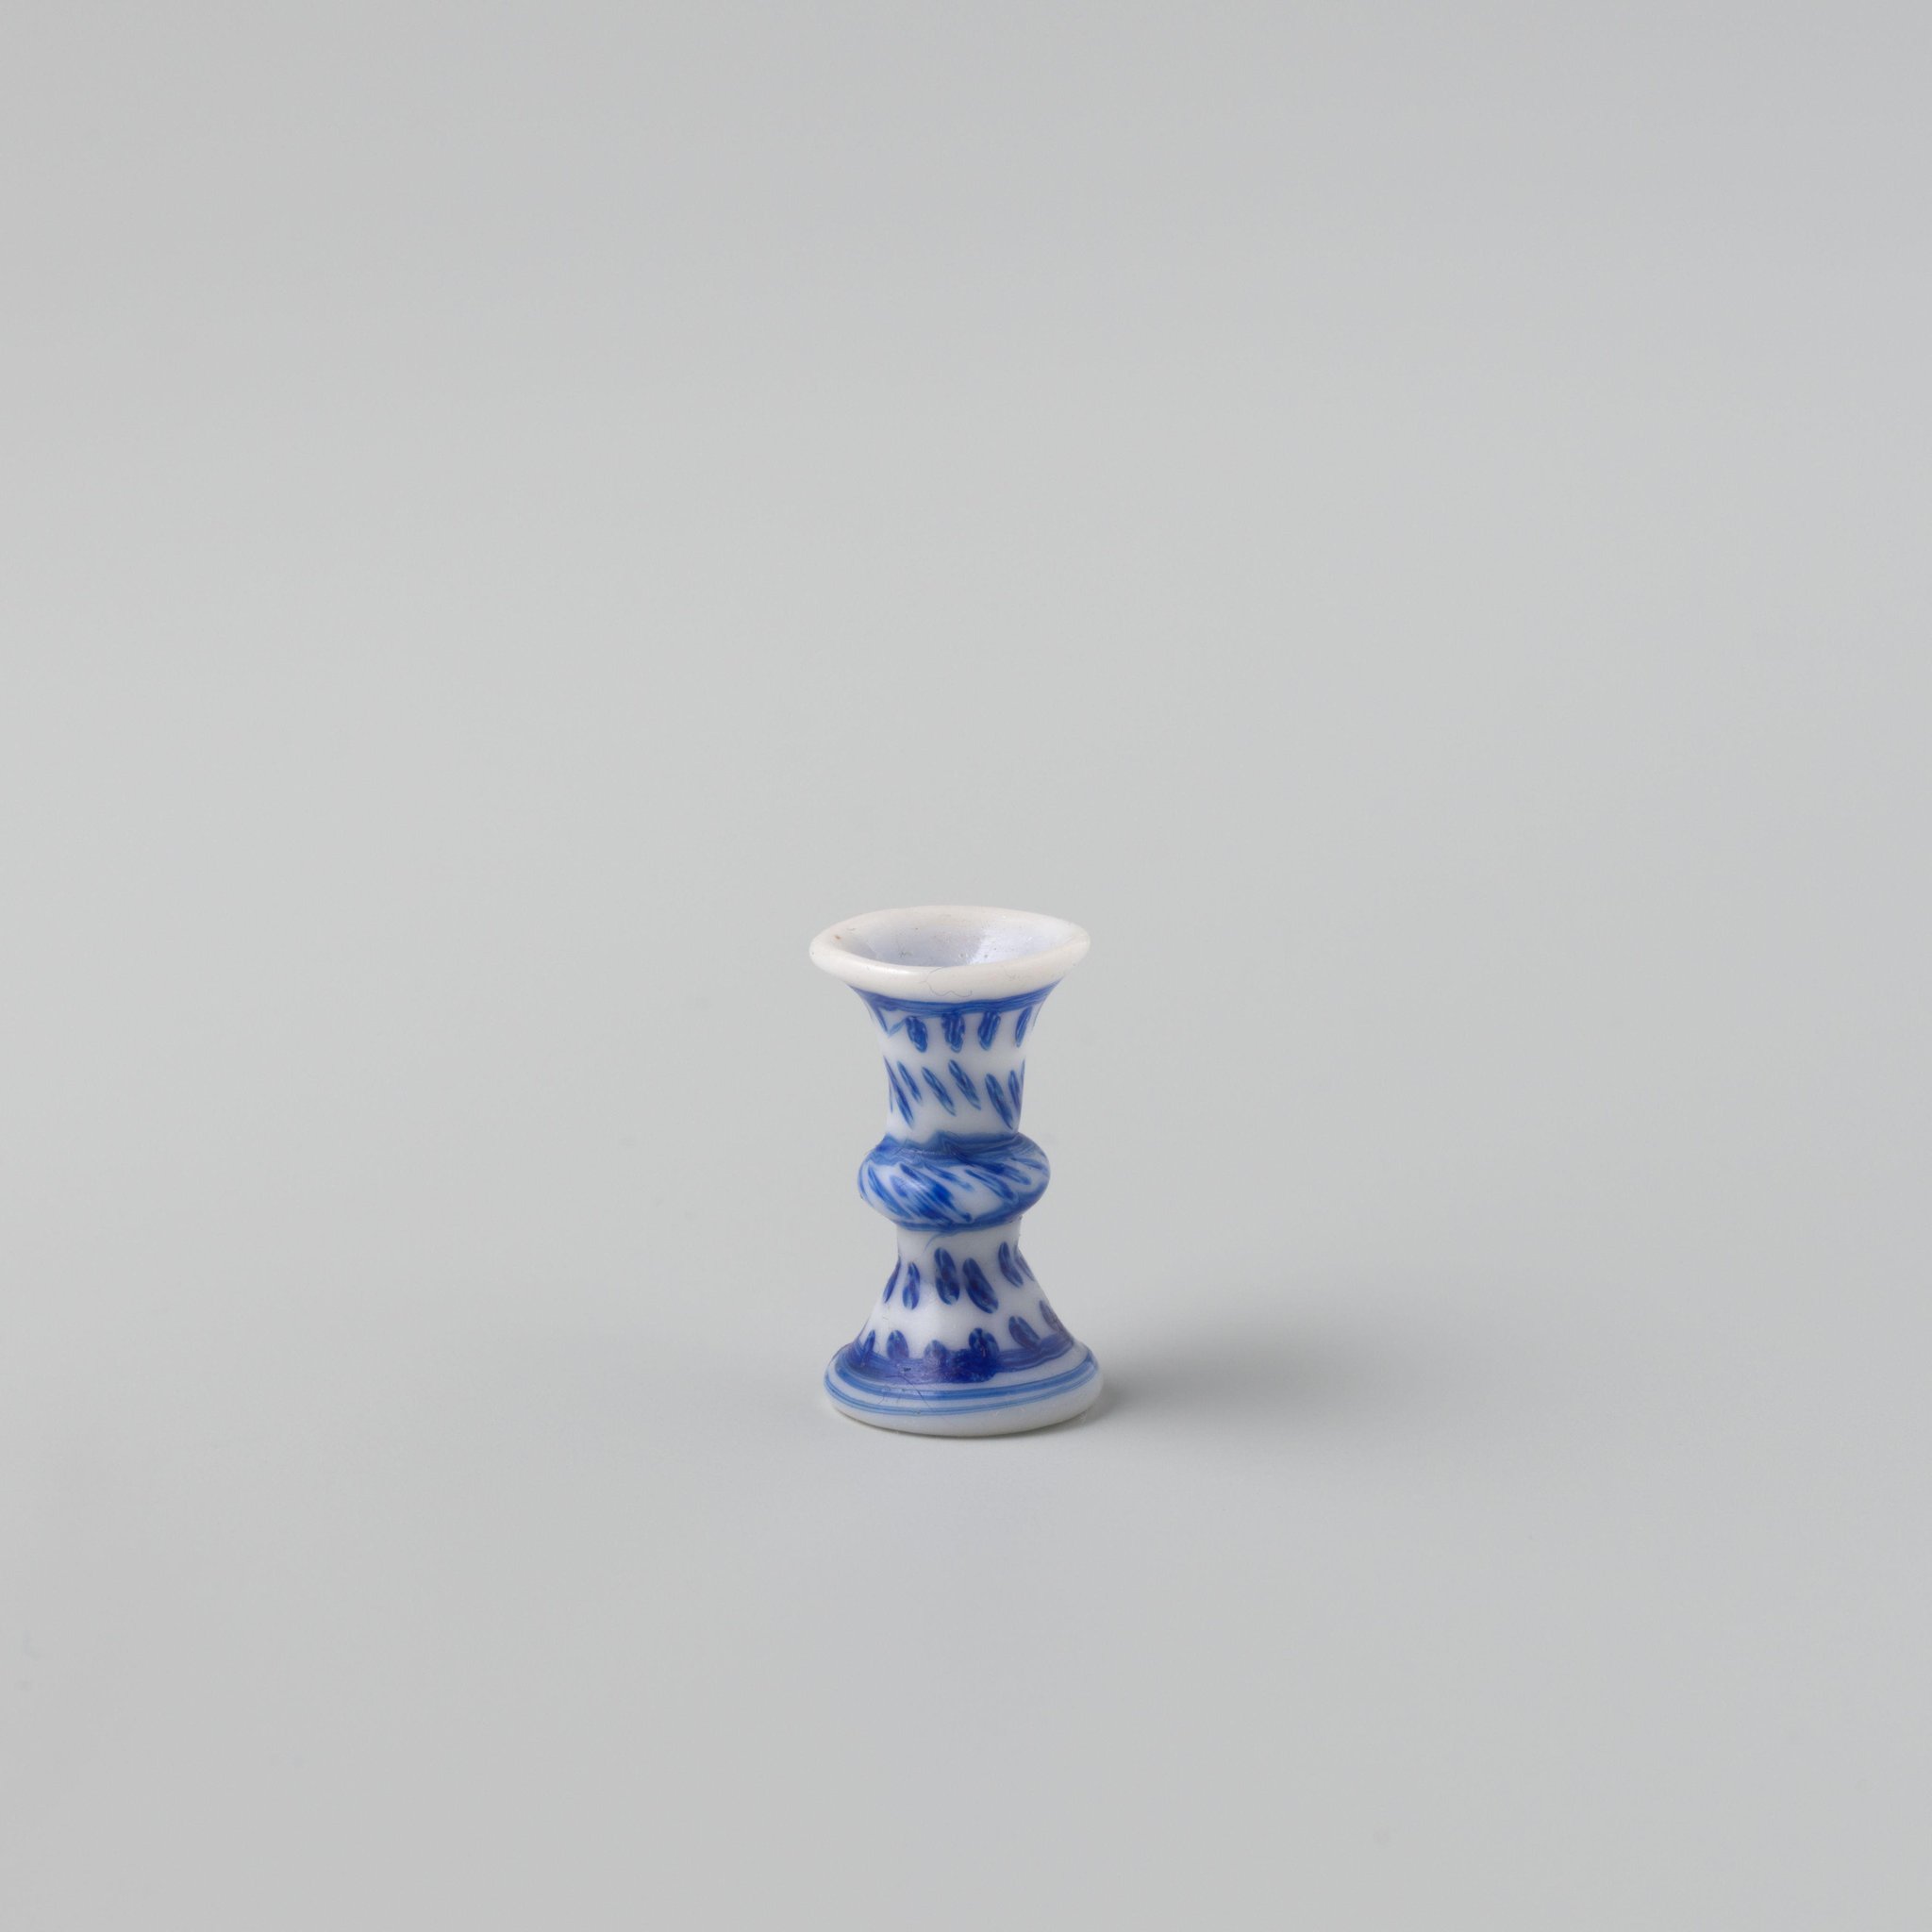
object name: vase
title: Vaas of beker van melkglas met blauwe emailverf beschildering, imitatie Chinees porselein; model met breed uitlopende voet en monding en verdikking in het midden, gestreept.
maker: Anonymous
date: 1675-1710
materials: glass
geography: amsterdam